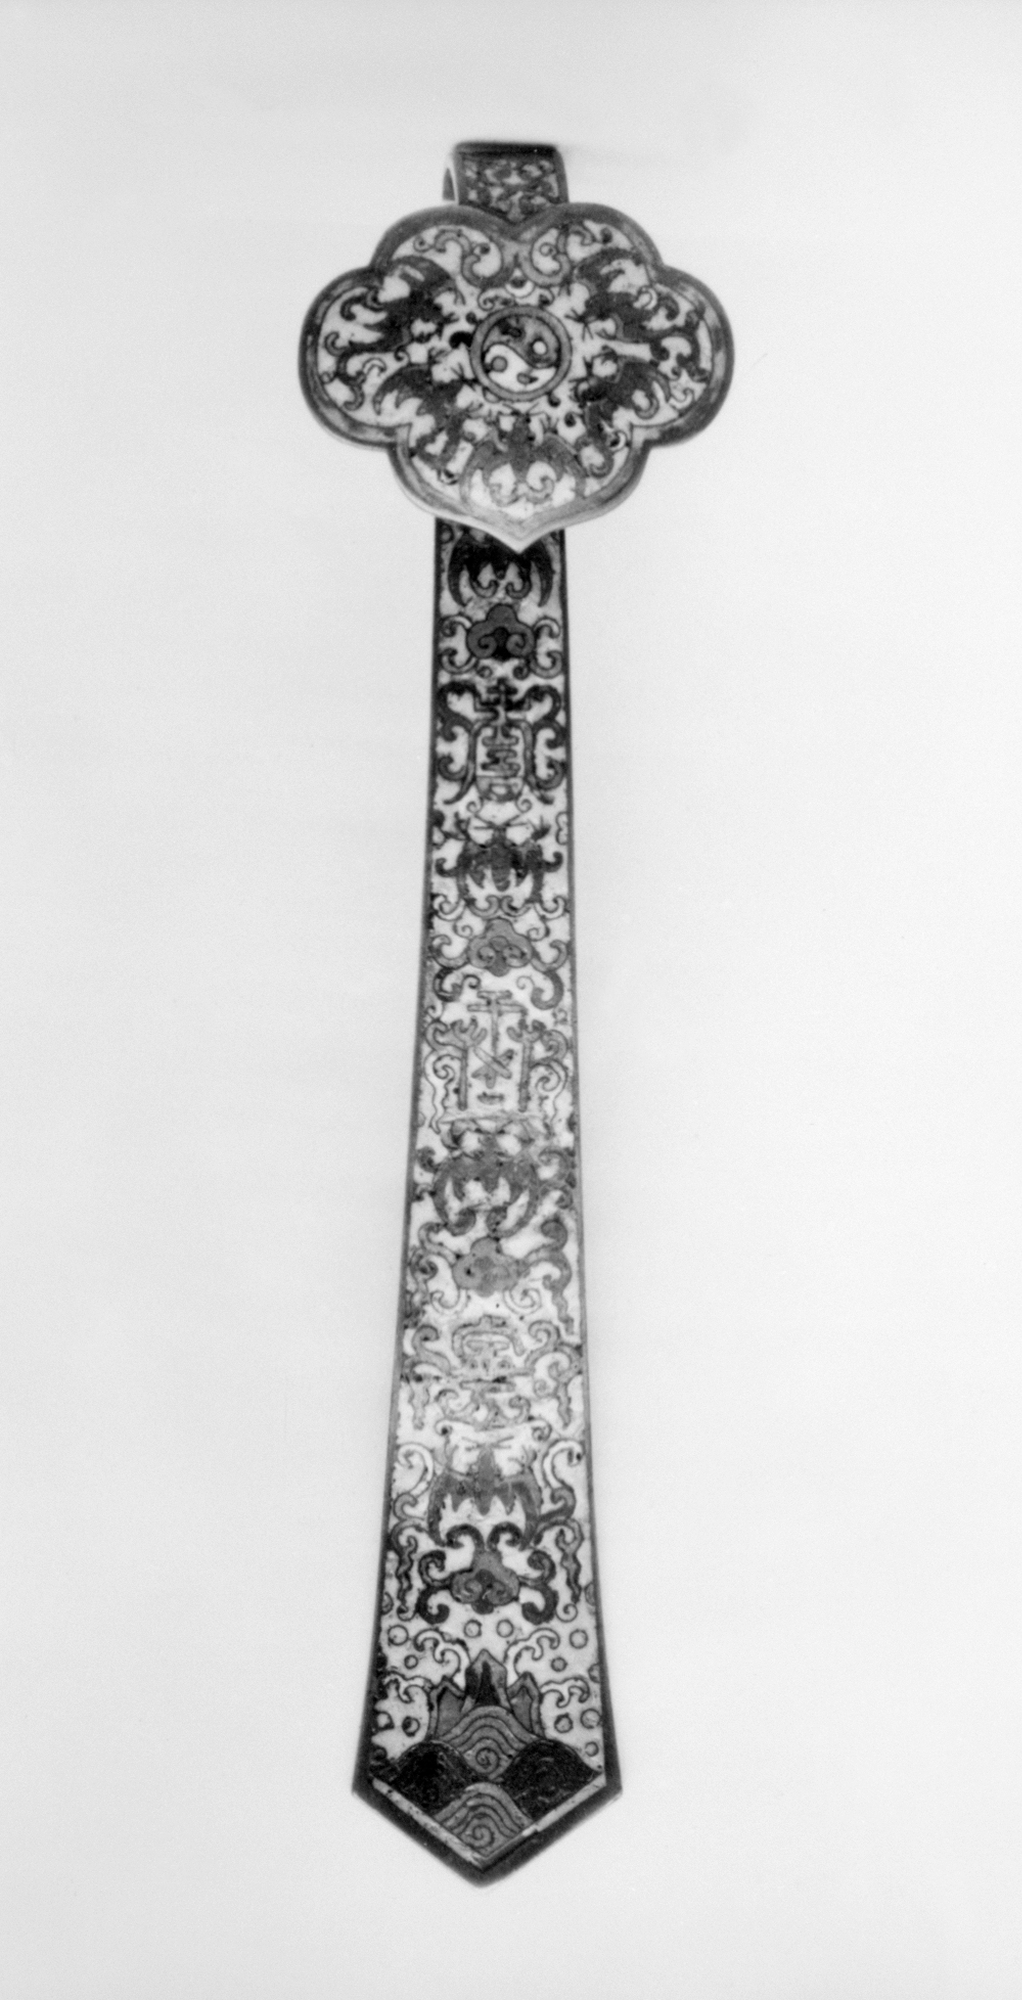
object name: ruyi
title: Ruyi (A Type of Decorative Accessory)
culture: chinese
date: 1567-1633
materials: enamel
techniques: enamel